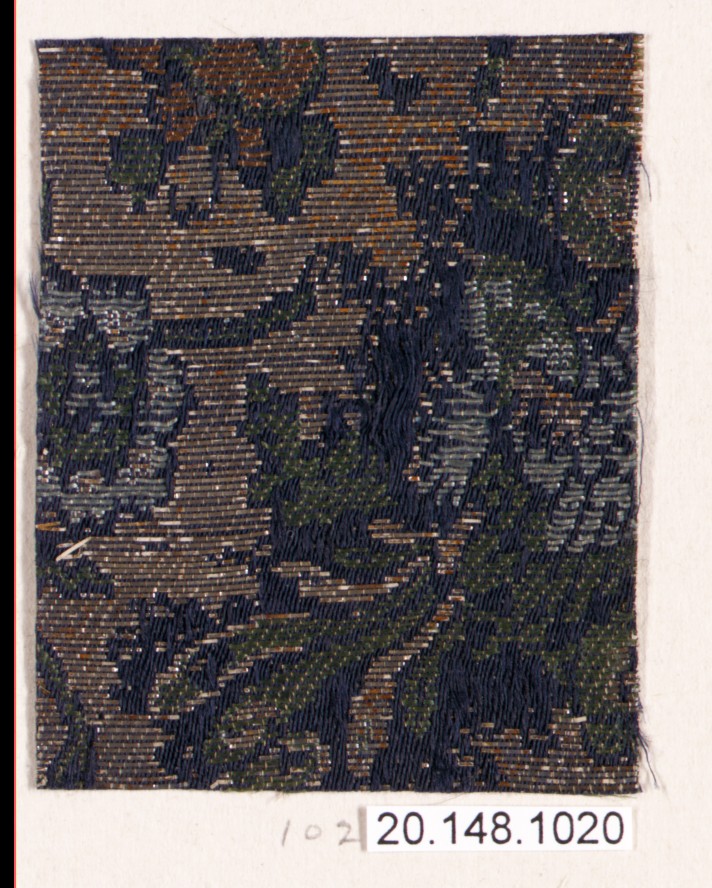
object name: piece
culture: japanese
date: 1601-1700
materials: silk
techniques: compound weave